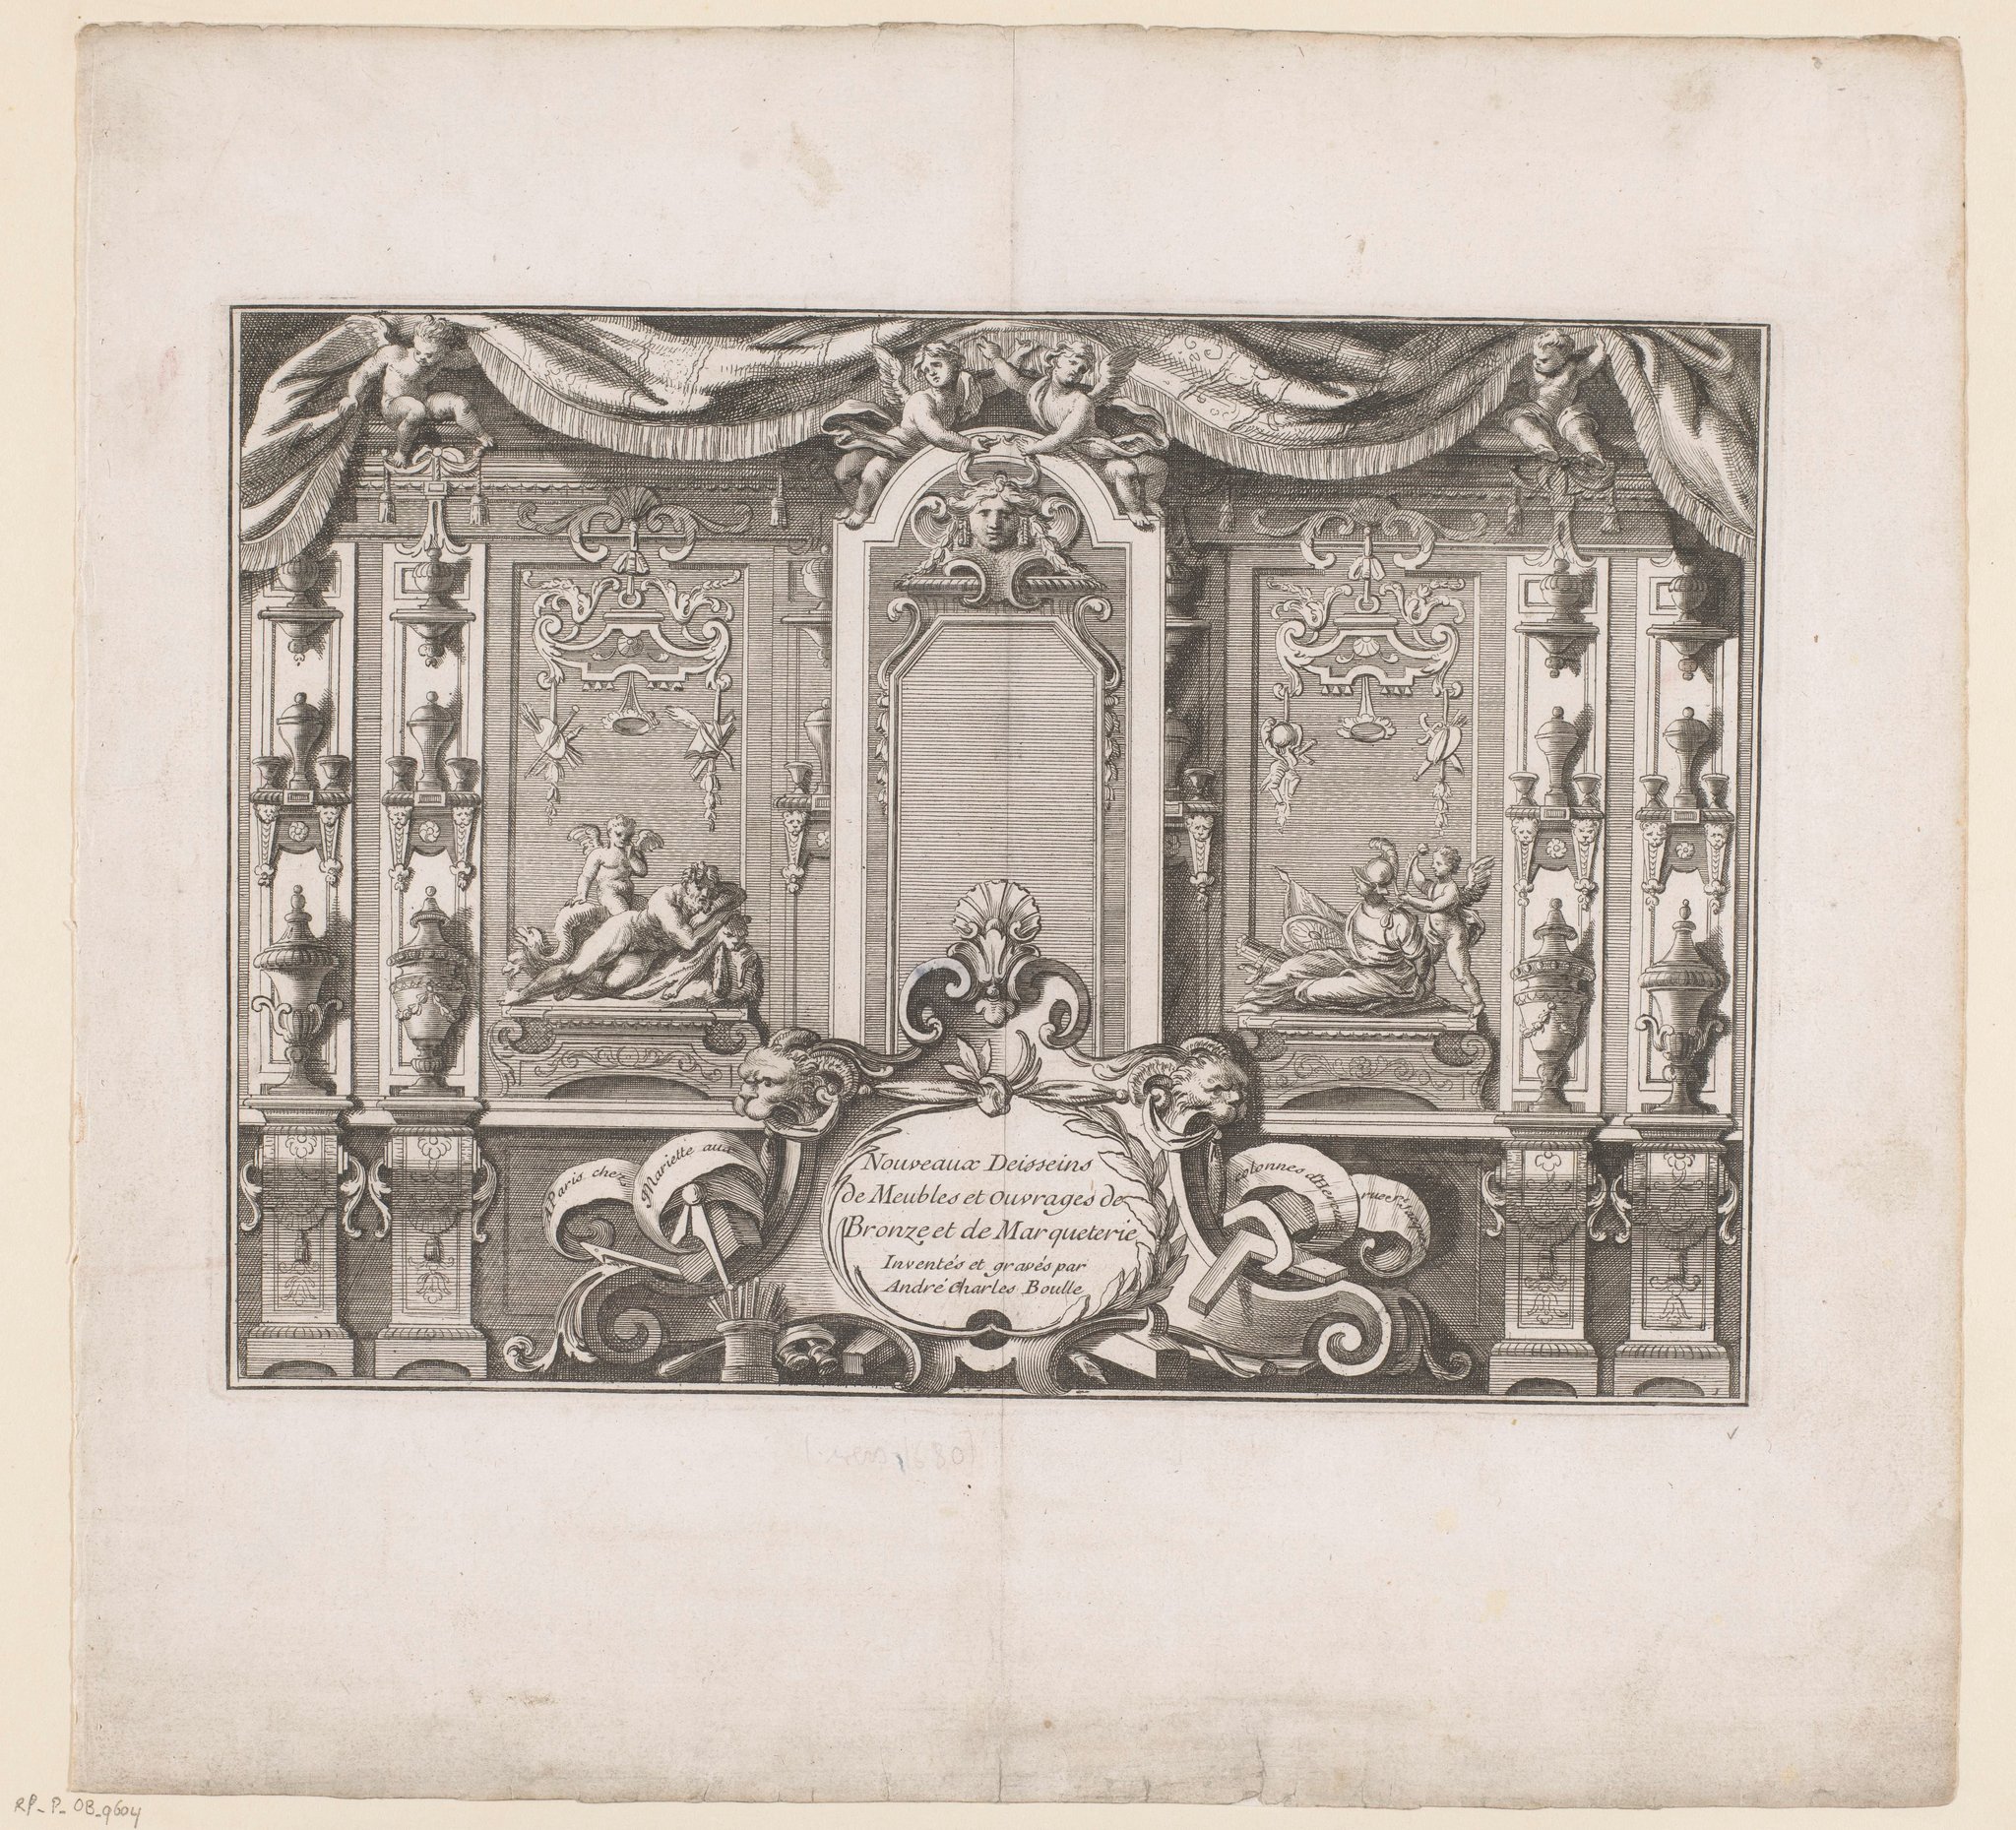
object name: print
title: Wanddecoratie met Hercules en Minerva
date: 1710-1720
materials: paper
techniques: etching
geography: paris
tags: (story of) hercules (heracles), (story of) minerva (pallas, athena), wall-covering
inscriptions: collector's mark: Lugt 2166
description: Een wanddecoratie met panelen met Hercules en Minerva met putti liggend op twee banken. Links en rechts pilasters met vazen. Midden onder een cartouche met dierenkoppen met hoorns en de serietitel.